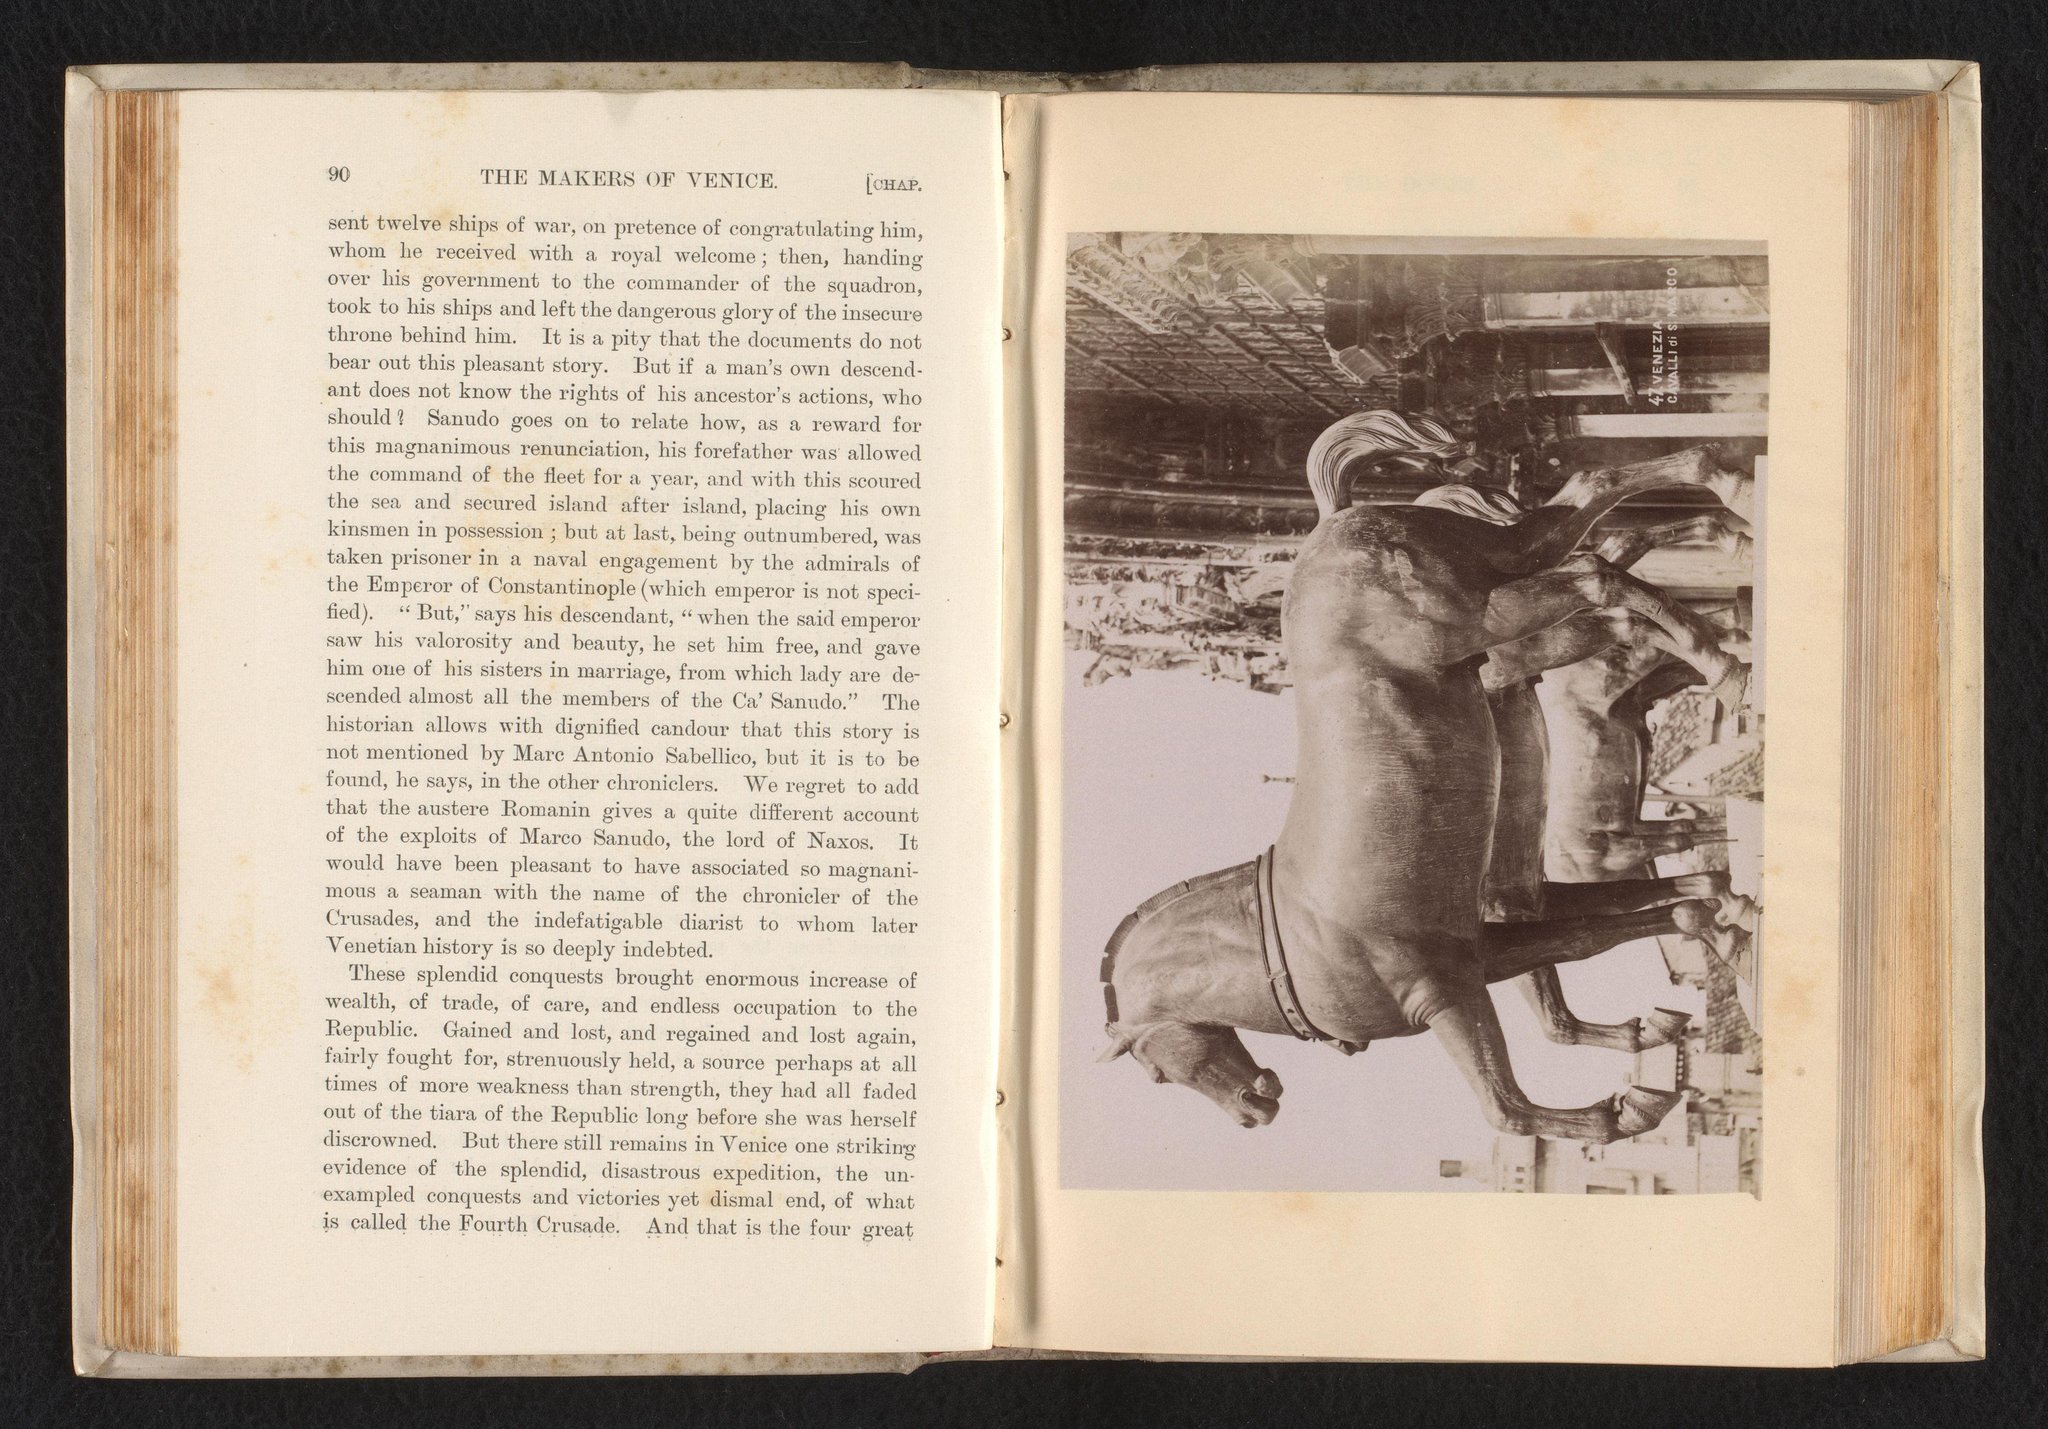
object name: page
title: Venezia, Cavalli di S. Marco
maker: Anonymous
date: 1888-1893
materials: paper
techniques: albumen print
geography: venice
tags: sculpture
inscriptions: number: ‘47.’